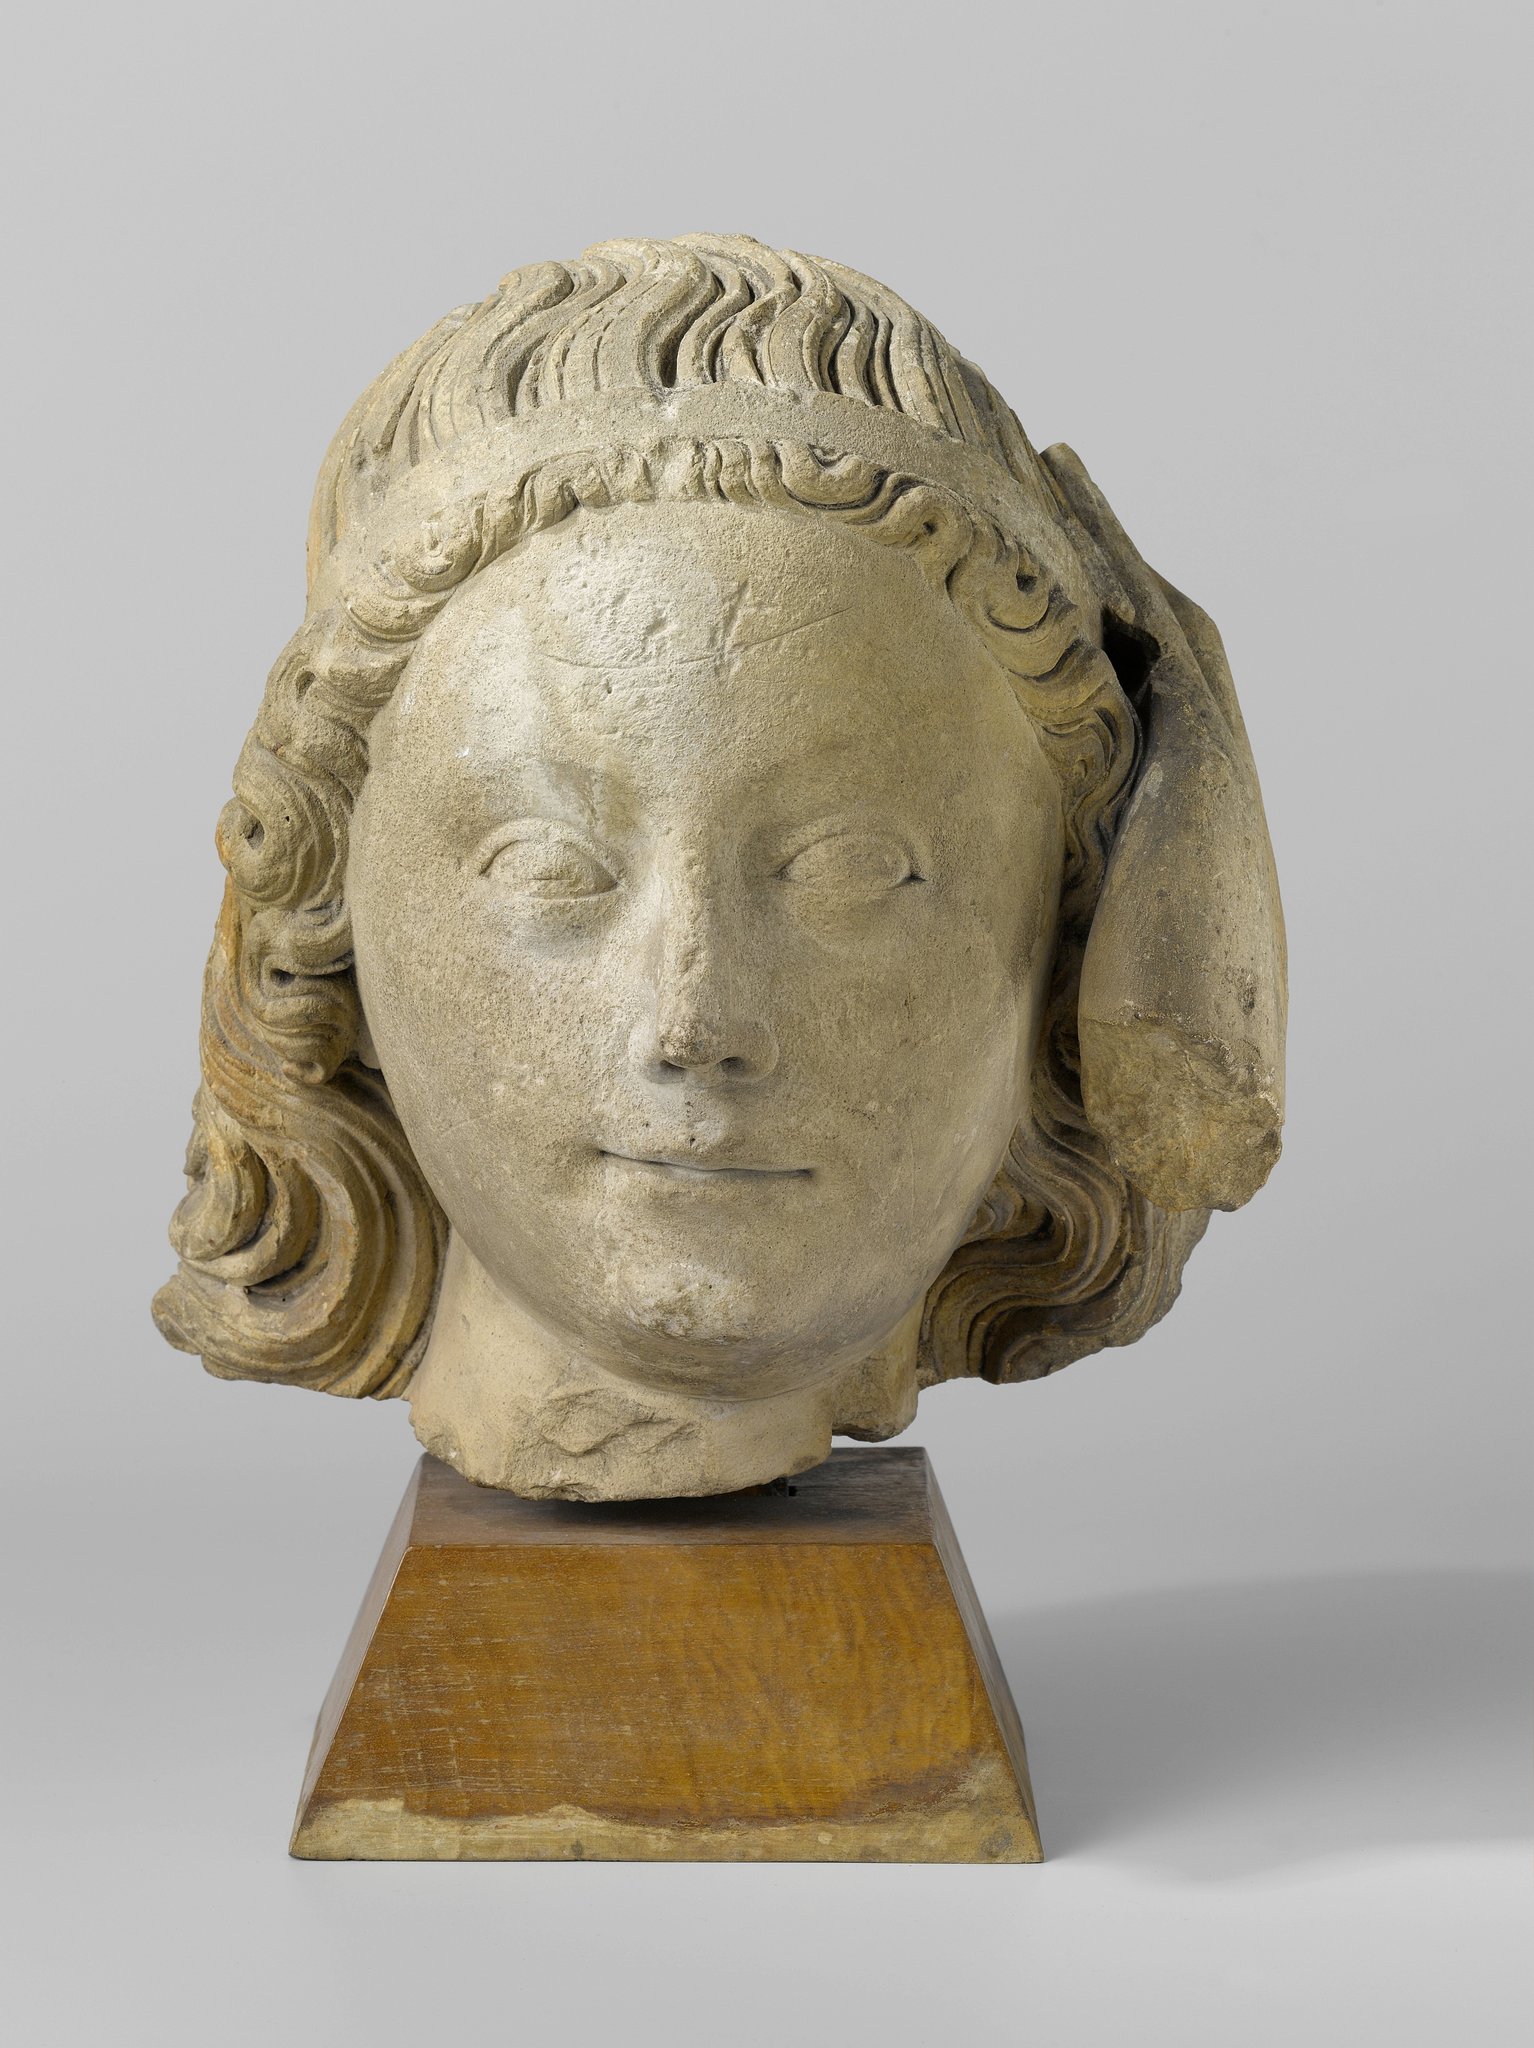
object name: sculpture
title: Kop van een engel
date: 1800-1900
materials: stone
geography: france